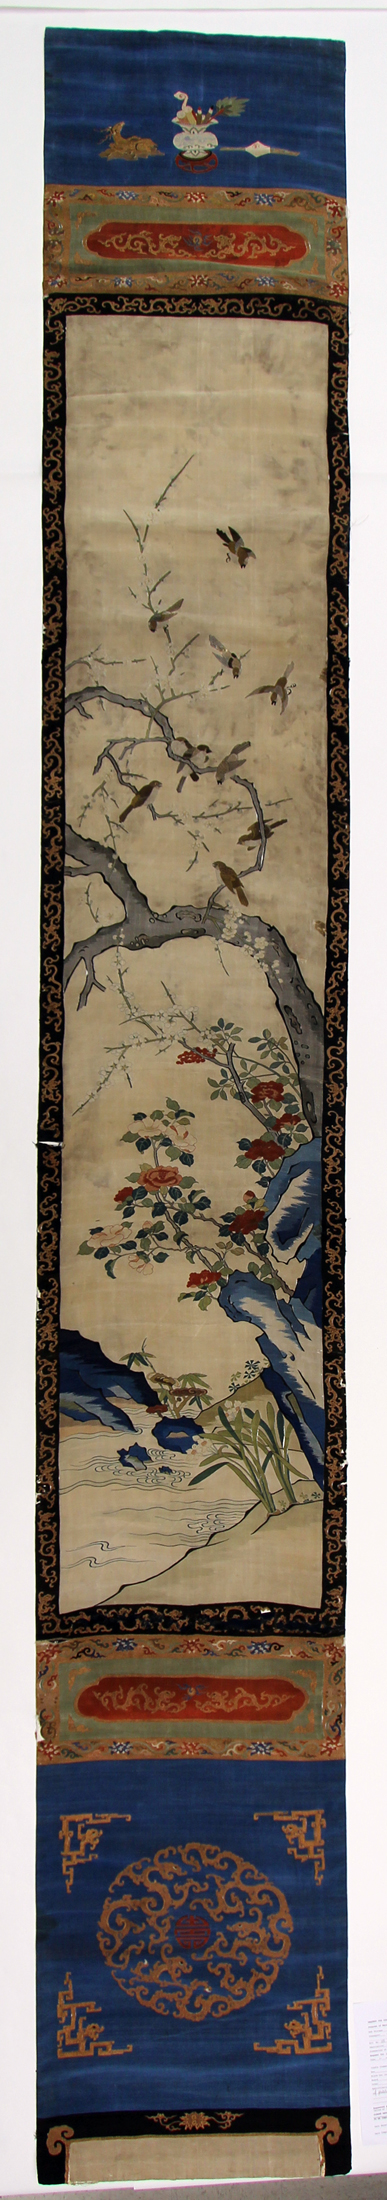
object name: picture, tapestry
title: Tapestry Picture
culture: chinese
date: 1767-1833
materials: metal thread, silk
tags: birds,trees